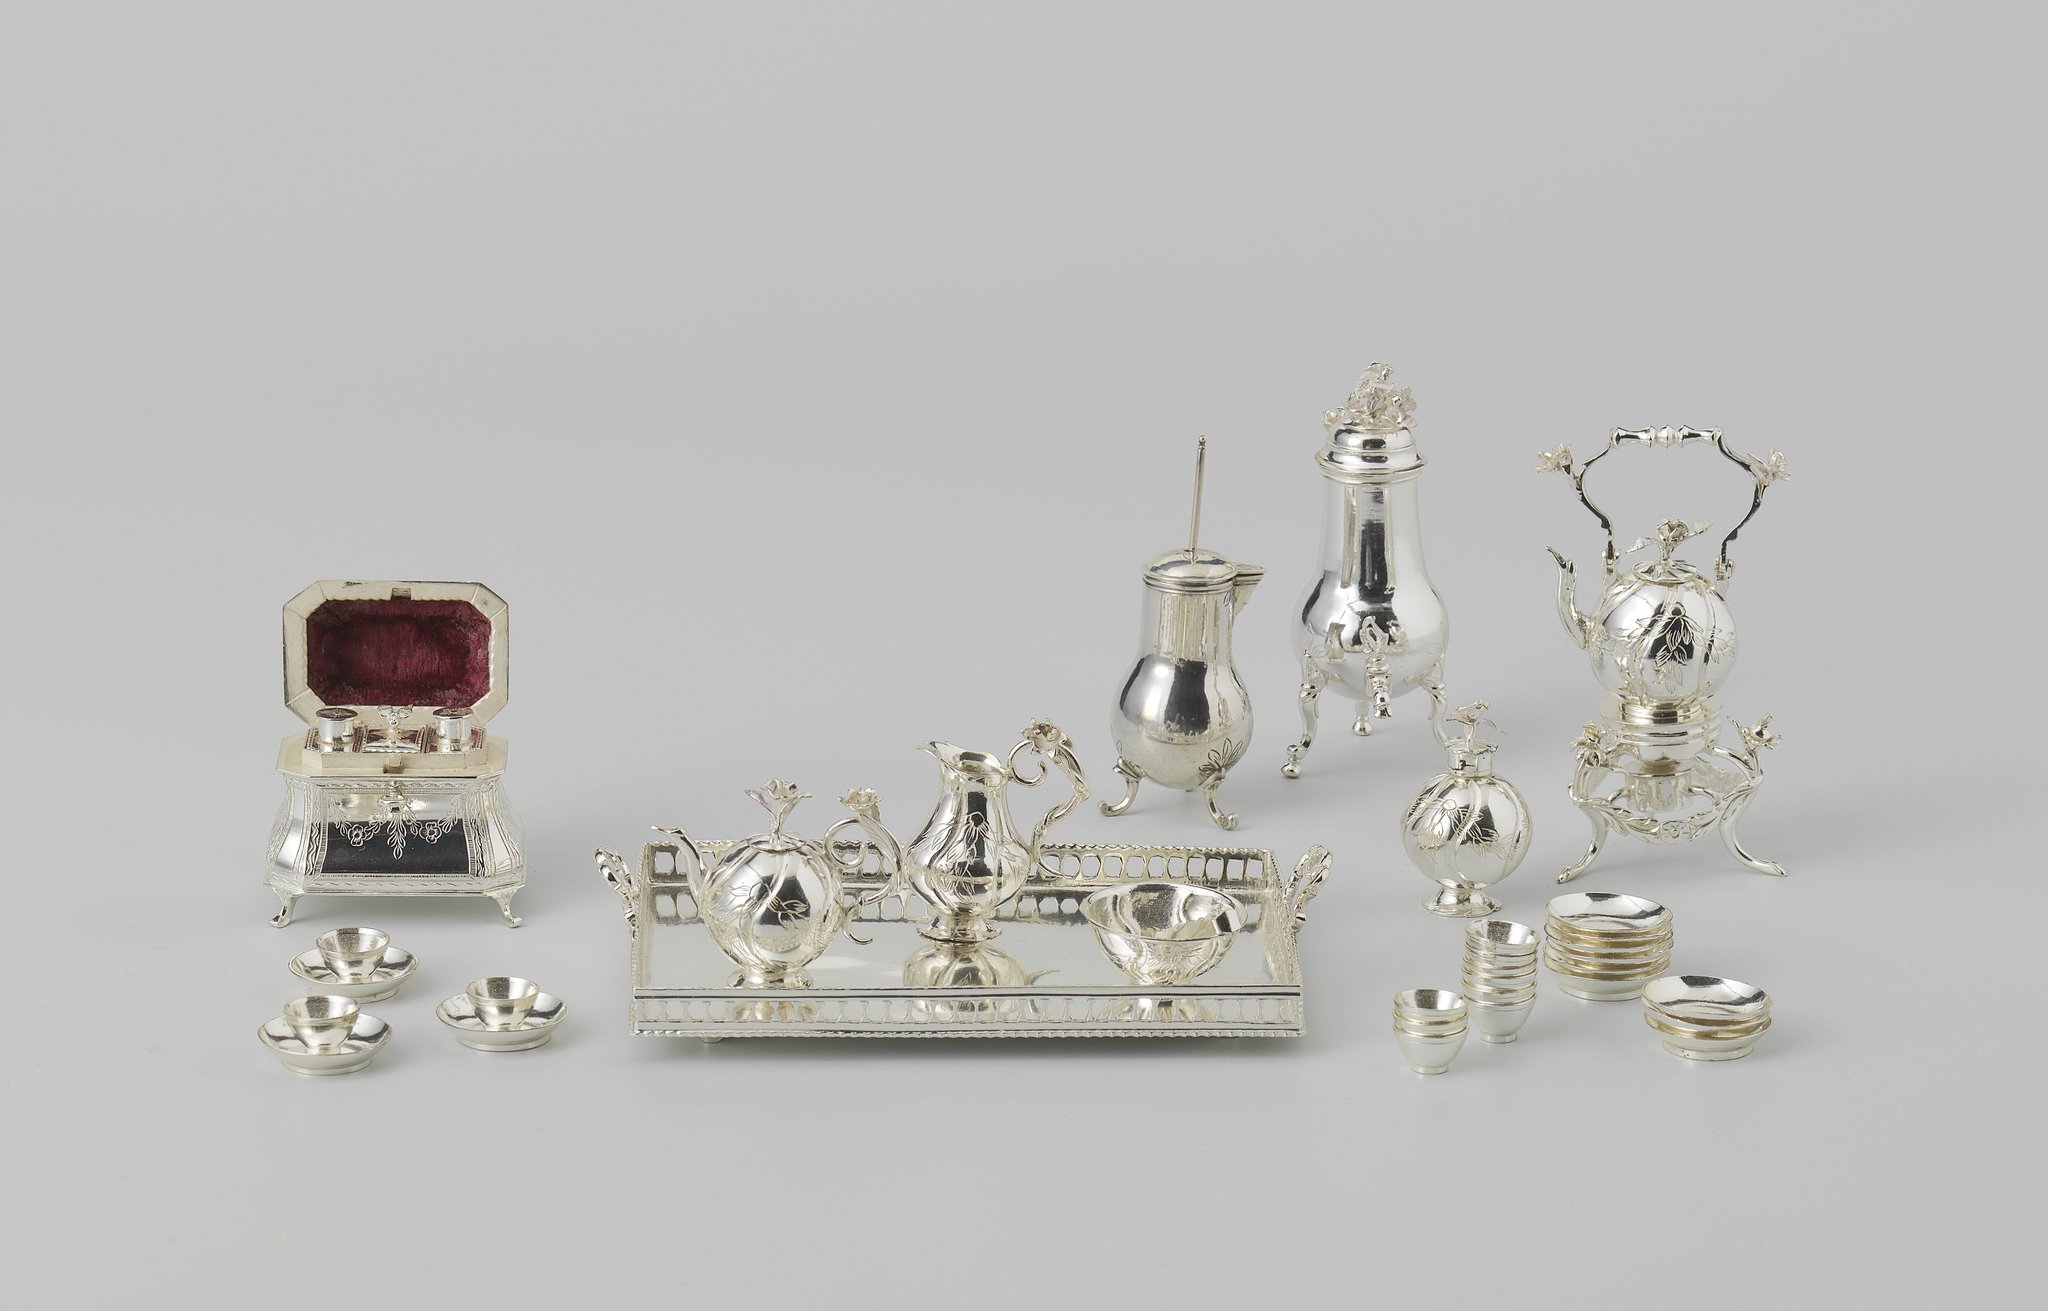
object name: miniature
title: Kop-en-schotel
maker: Anonymous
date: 1775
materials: silver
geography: amsterdam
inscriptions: maker's mark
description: Trechtervormige theekop op een schotel. De schotel heeft een opstaande rand, is onversierd en gemerkt: mt.= Voet 430. De theekop is langs de bovenrand gegraveerd en is niet gemerkt. De kop en schotel worden bewaard als onderdeel van een theeservies (BK-NM-11177-142). Het theeservies heeft in het totaal twaalf kop en schotels die gelijk zijn aan dit exemplaar.